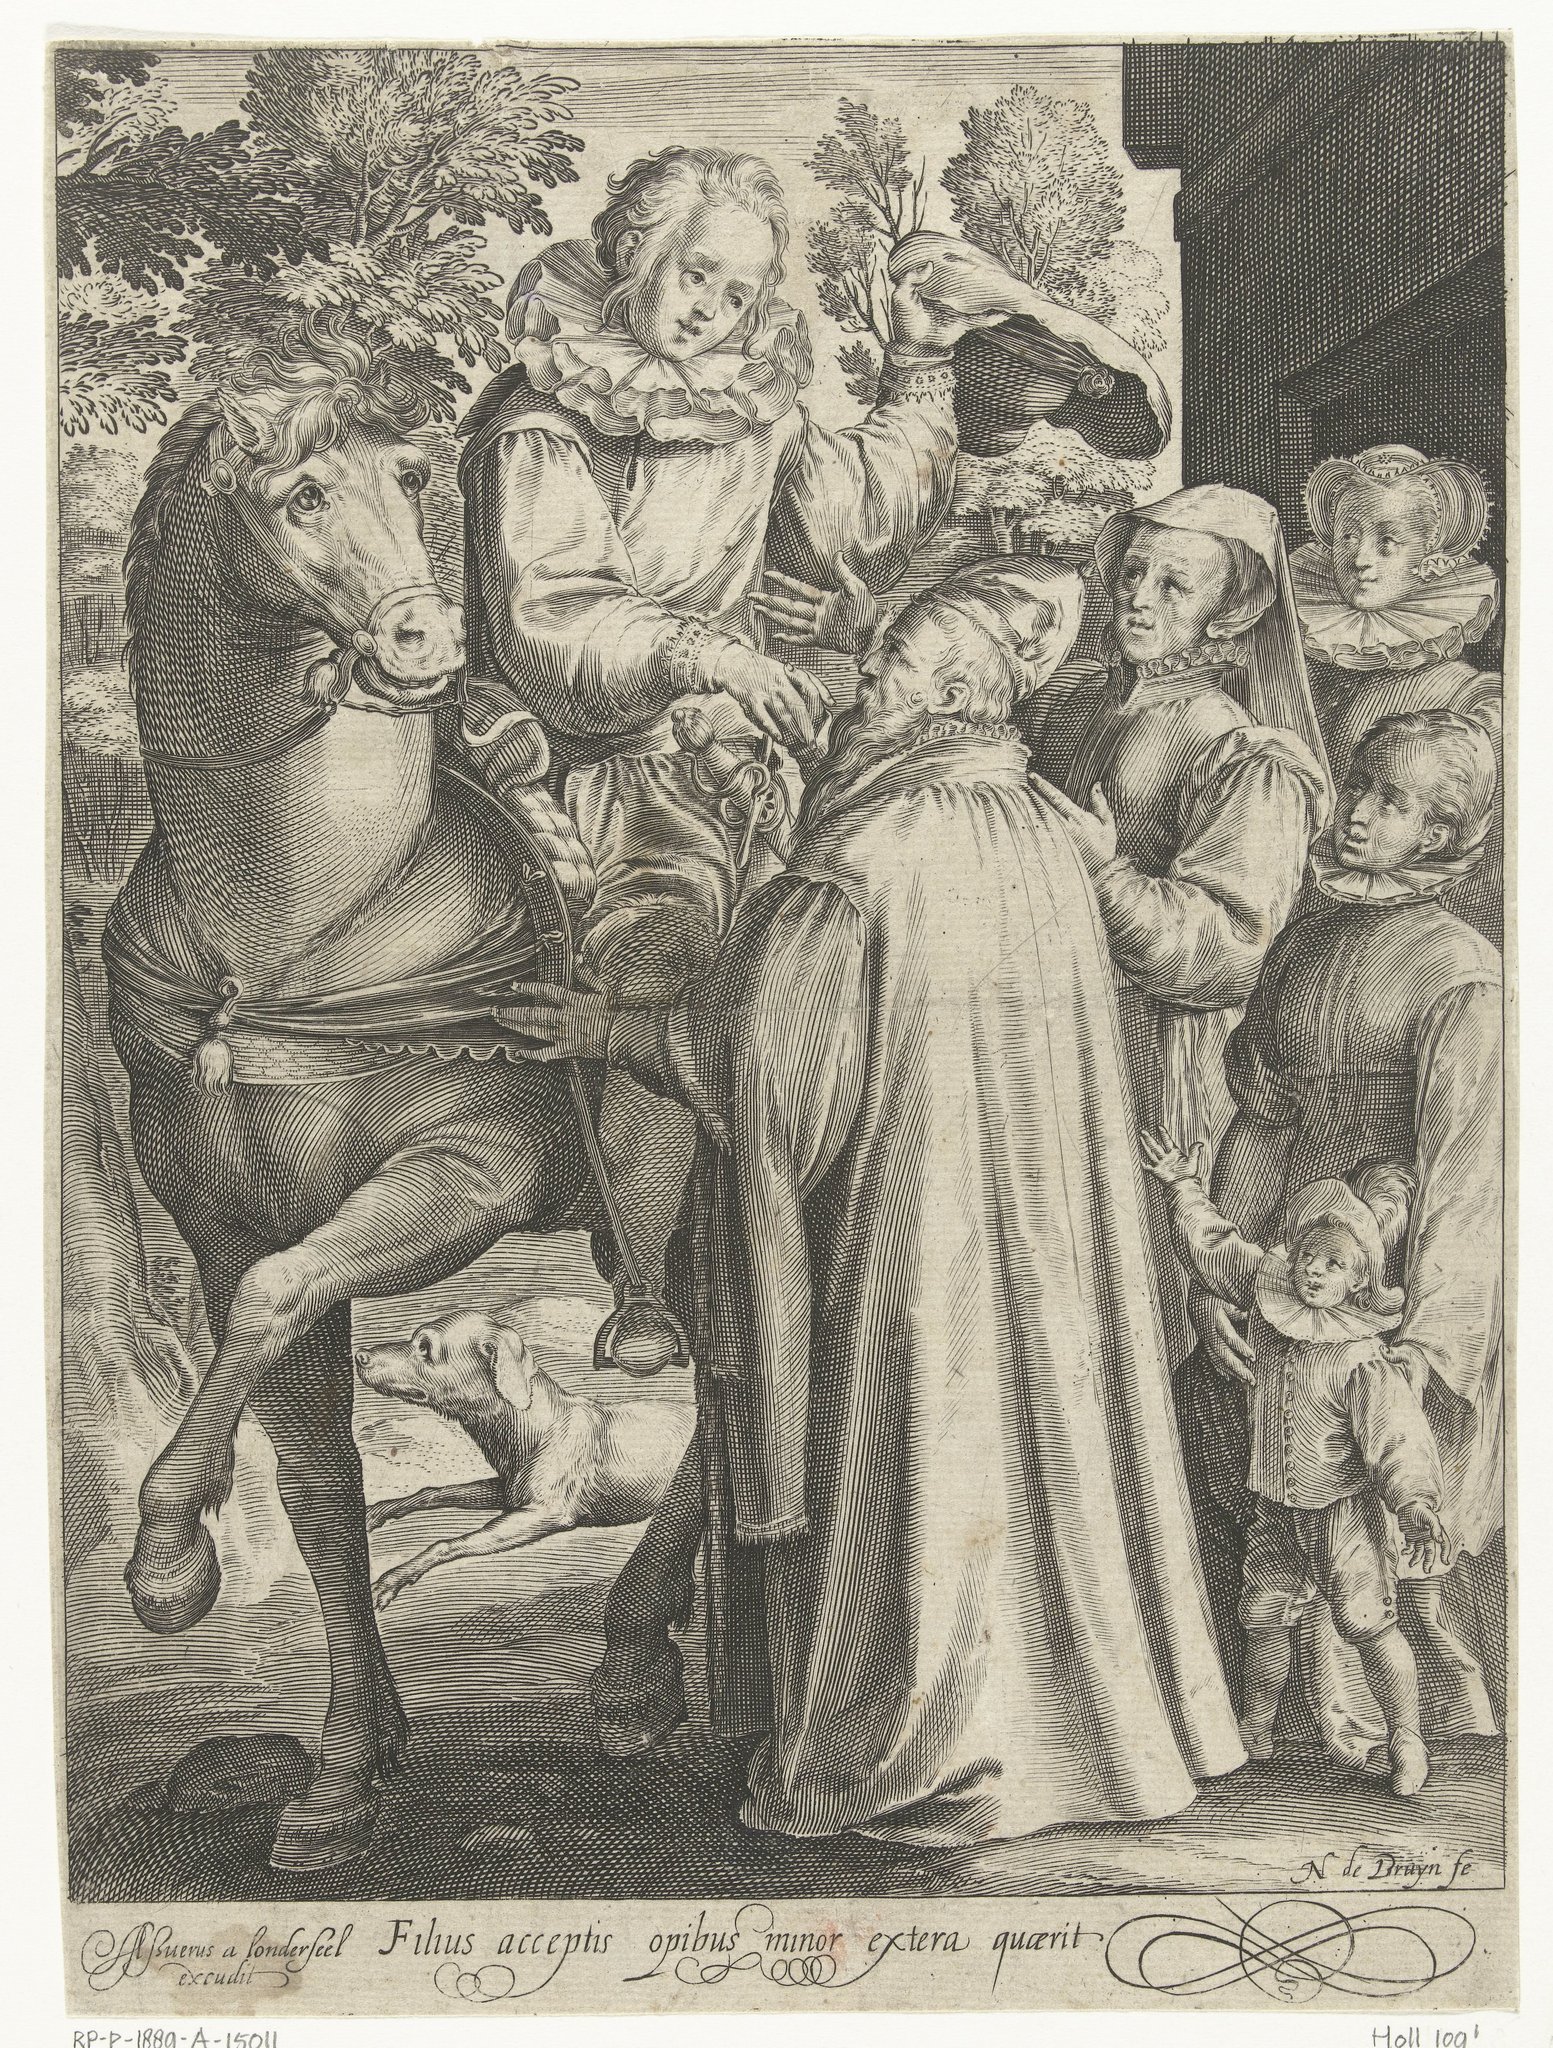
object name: print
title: De verloren zoon ontvangt zijn erfdeel en gaat op reis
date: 1581-1656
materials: paper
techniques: engraving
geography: netherlands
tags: riding a horse, ass, or mule; rider, horseman, waving farewell ~ departure on a journey, leave-taking and departure of the prodigal son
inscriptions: collector's mark: Lugt 2228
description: De verloren zoon ontvangt zijn erfdeel van zijn vader en neemt afscheid van zijn familie. Hij zit al op zijn paard en wuift met zijn hoed.